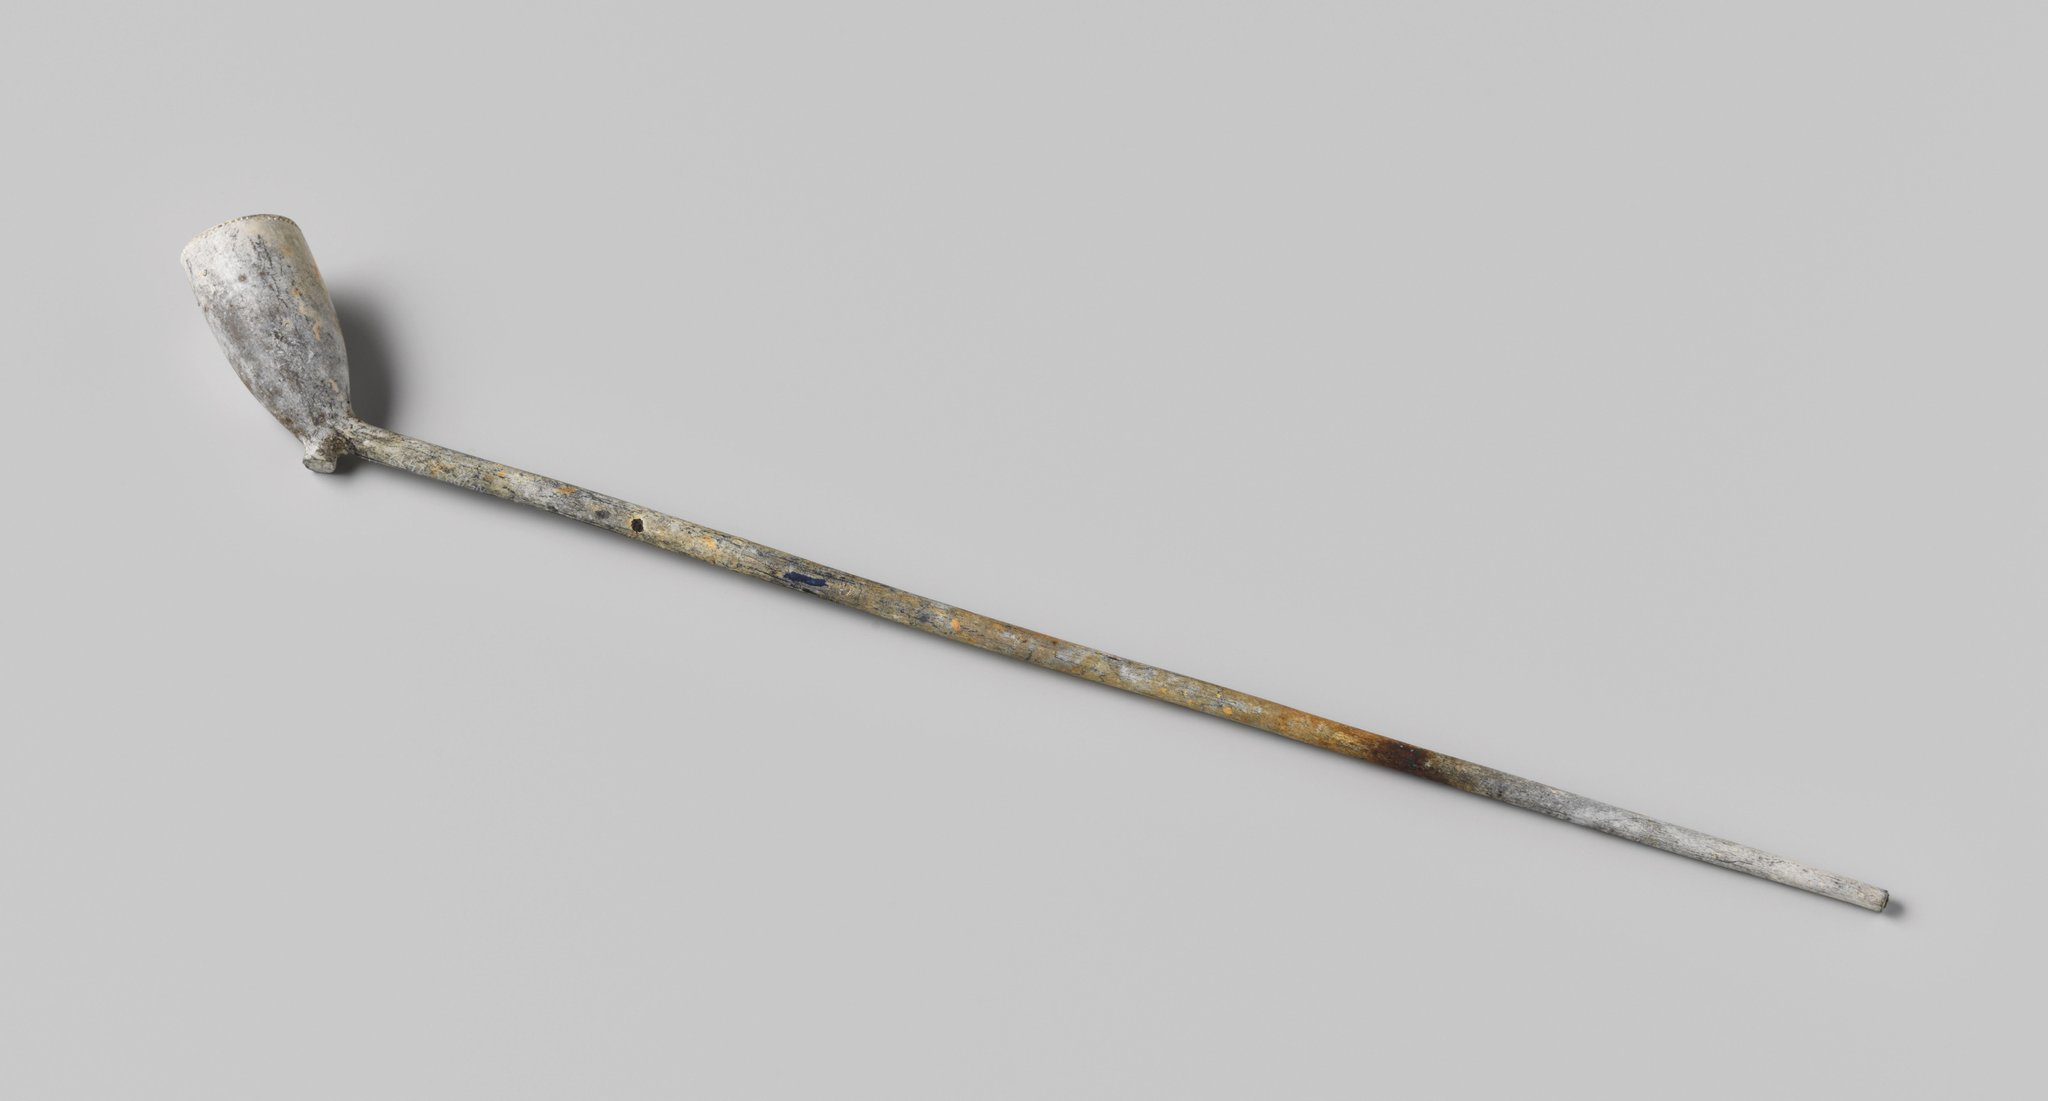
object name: pipe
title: Pijp uit het wrak van de Oost-Indiëvaarder 't Vliegend Hart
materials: clay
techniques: firing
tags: 't vliegend hart (schip), verenigde oostindische compagnie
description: Aarden Goudse pijp. Intact. Letters: VAN en DEVELD. Heeft een hielmerk. Grijsblauwe kleur.